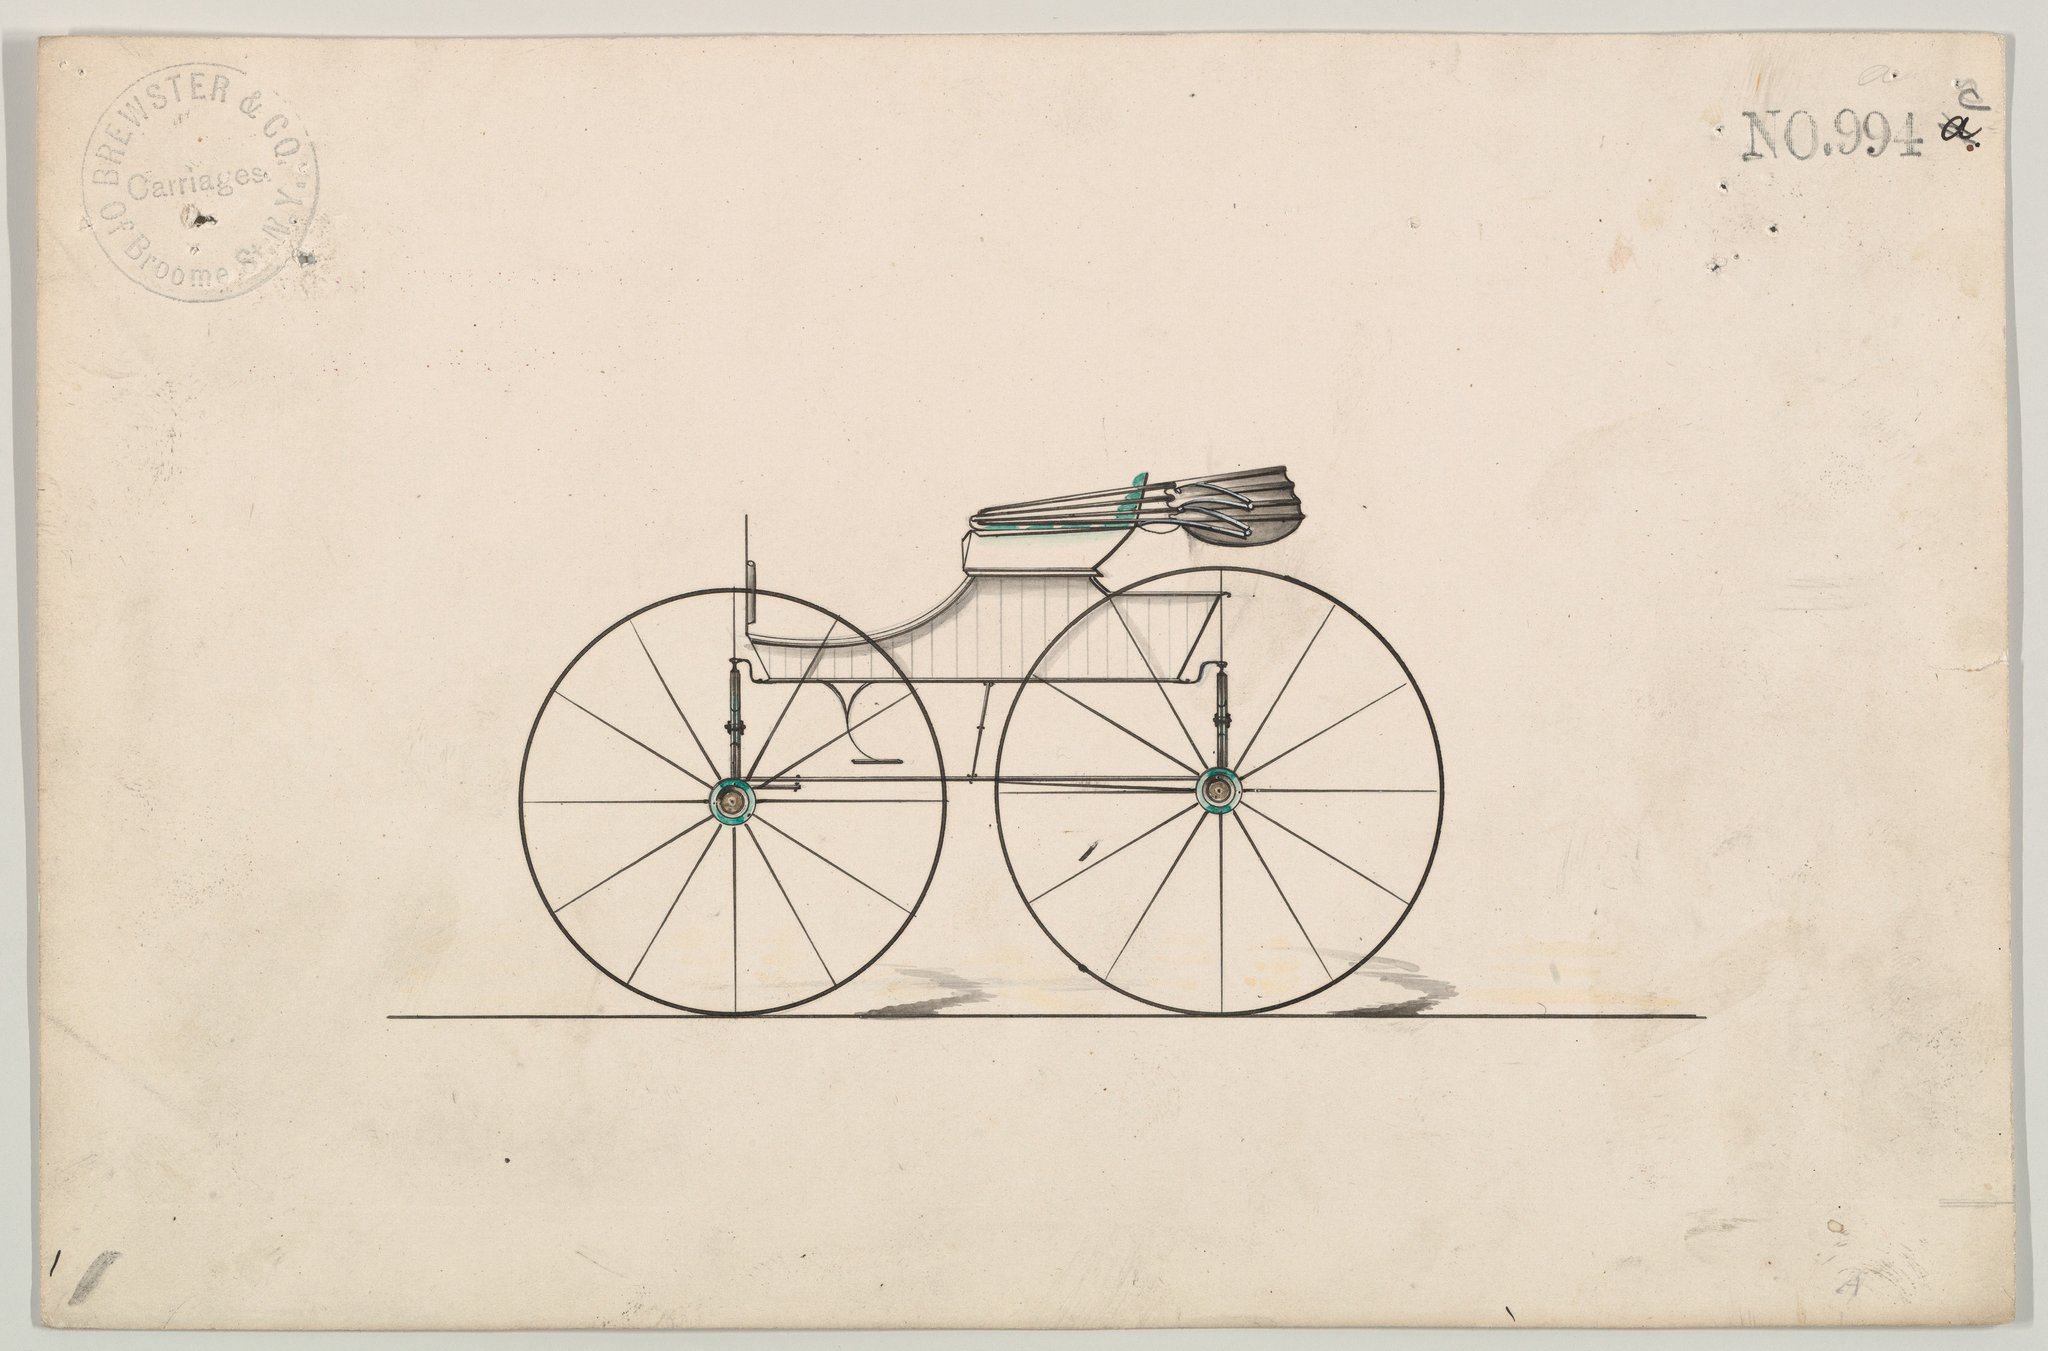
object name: drawing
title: Design for Wagon, no. 994c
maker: brewster & co.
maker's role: manufacturer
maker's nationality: american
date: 1870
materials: gouache, ink, watercolor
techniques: pen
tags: carriages